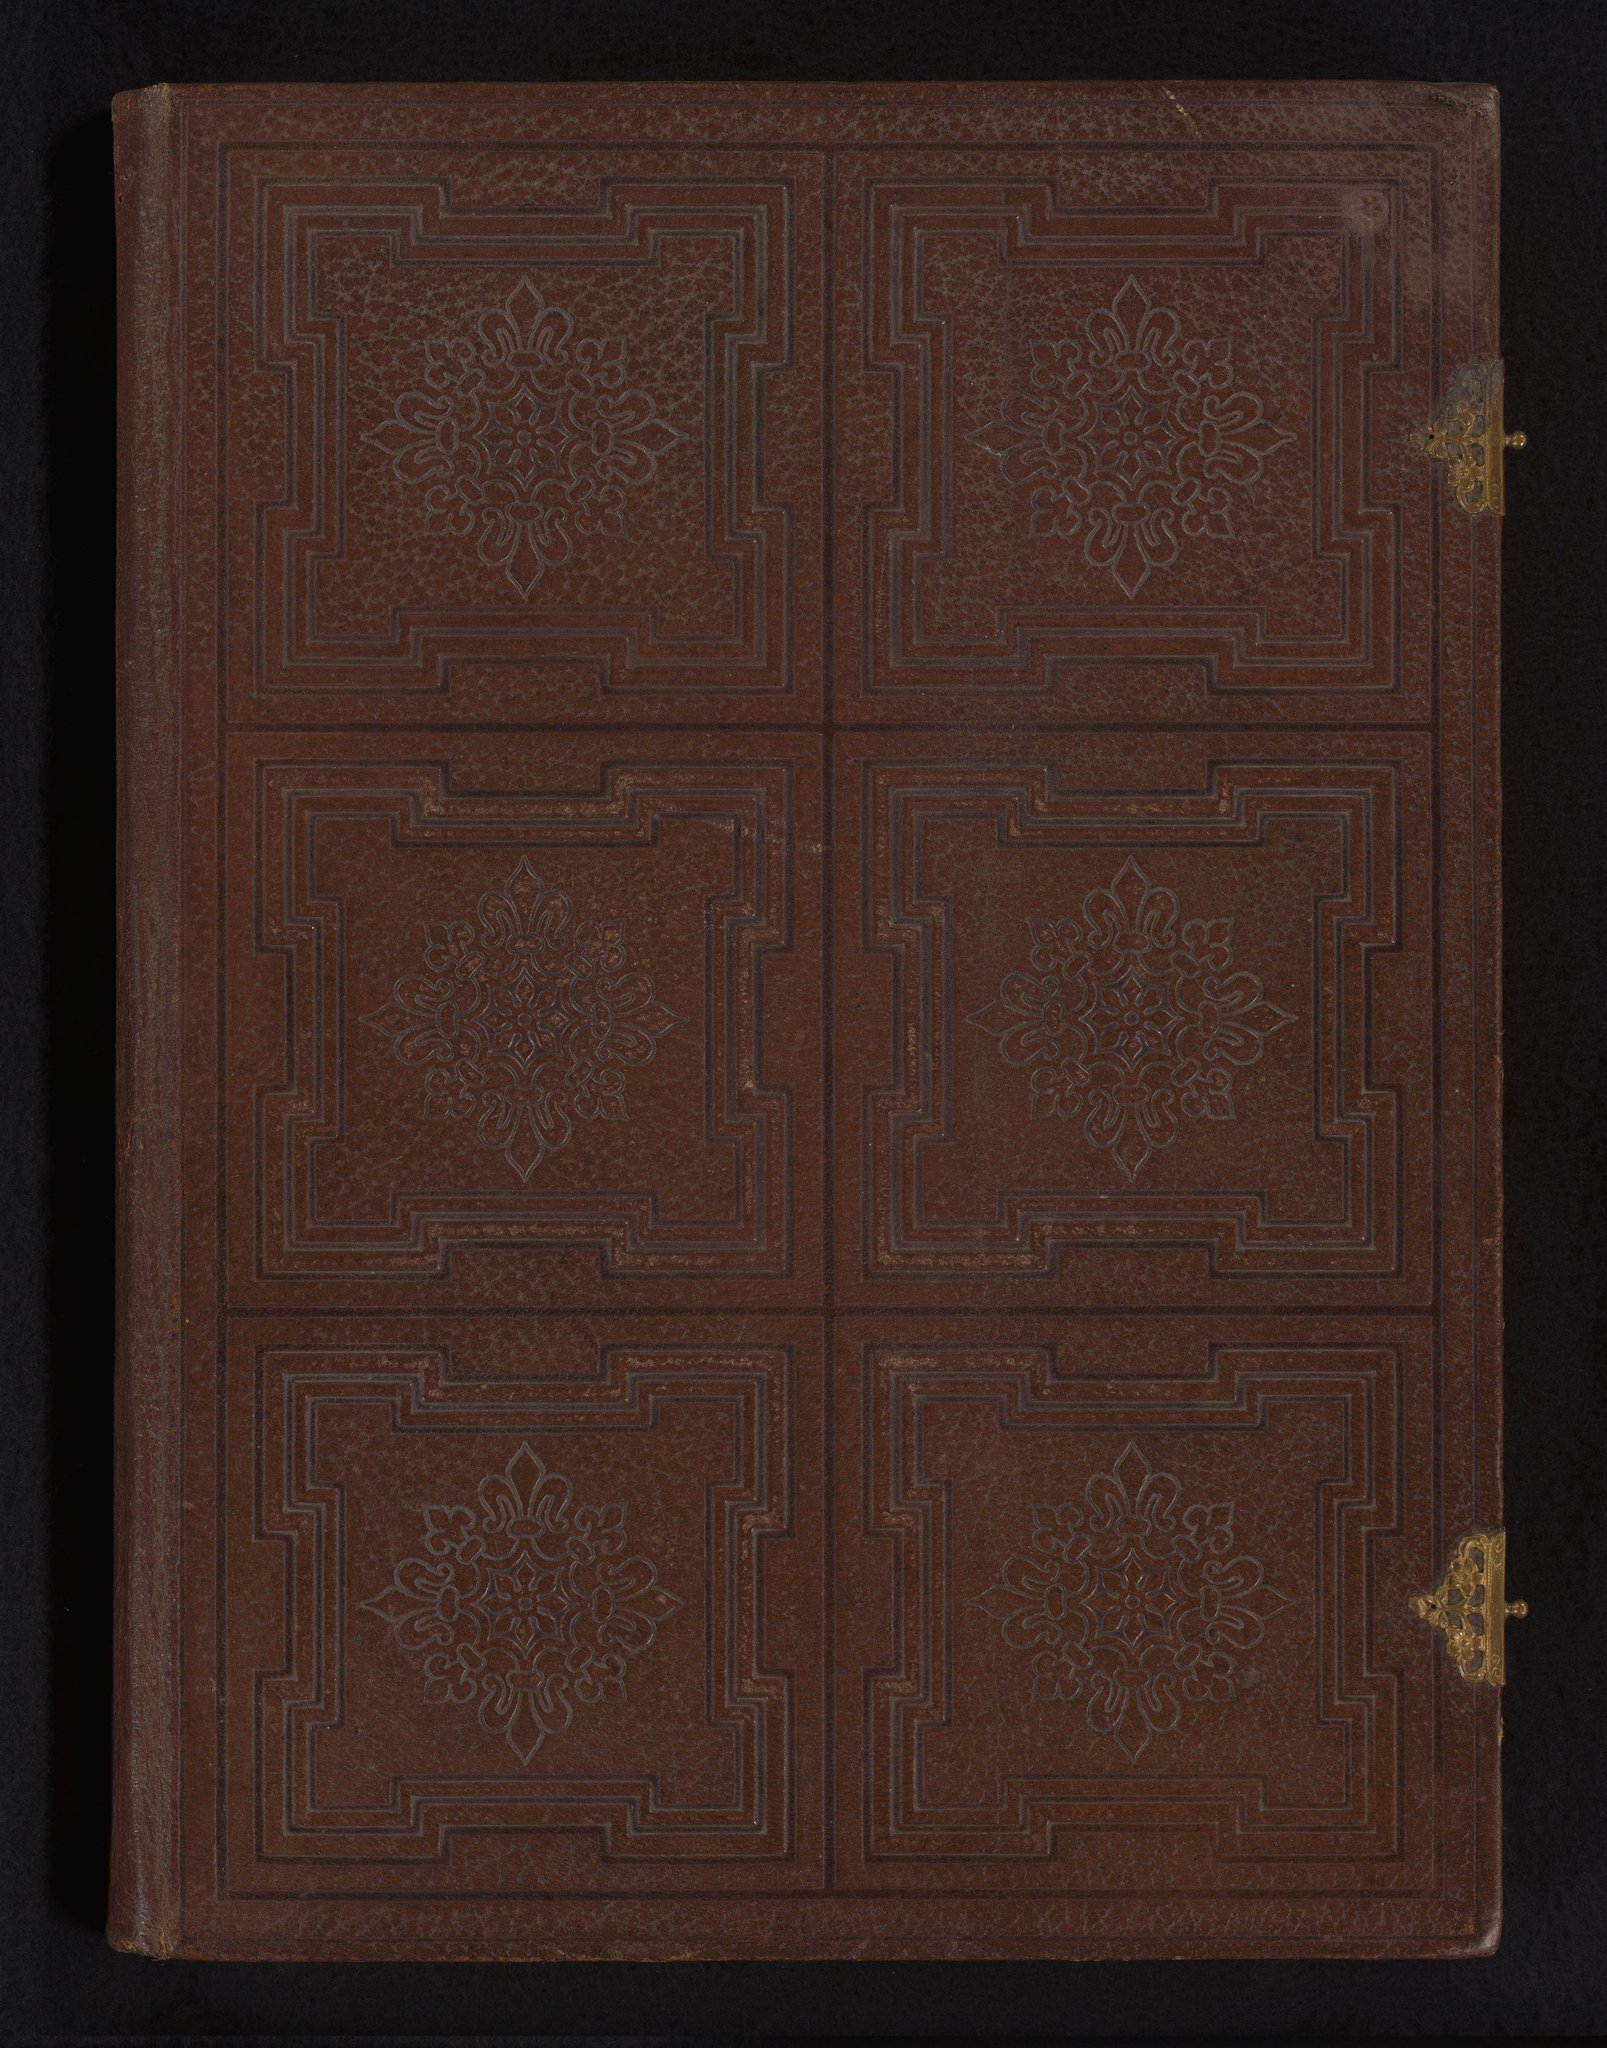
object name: slip in album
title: Nederlands familiealbum met 68 foto's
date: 1860-1880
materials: cardboard, leather, metal, paper, photographic support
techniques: albumen print, carbon print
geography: haarlem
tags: historical persons - bb - woman, child, historical persons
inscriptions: collector's mark: ‘DIENST/ VERSPREIDE/ RIJKSKOLLEKTIES/ (...) A 1035’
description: Fotoalbum met in totaal 68 foto's op 18 pagina's. Iedere pagina bevat 4 cartes-de-visite in met gepreegde rand omkaderde passe-partouts. Niet alle passe-partouts in het album zijn gevuld. Afgebeeld zijn portretten van leden van een familie, mogelijk gerelateerd aan de familie Van Braam van de albums RP-F-F00663, RP-F-F00664 en RP-F-F00665. Op de eerste albumbladen zijn door verzamelaar L.J. Hartkamp namen van en aantekening over de geportretteerden geschreven. De familienamen Meyer, Bletz en Kerkhoff zijn vermeld. De cartes-de-visite kunnen niet uit het album worden gehaald, waardoor van slechts 3 foto's de fotograaf bekend is, te weten de Nederlandse fotografen H.Ph.J. Schuiten, L.R. Werner en Binger's.